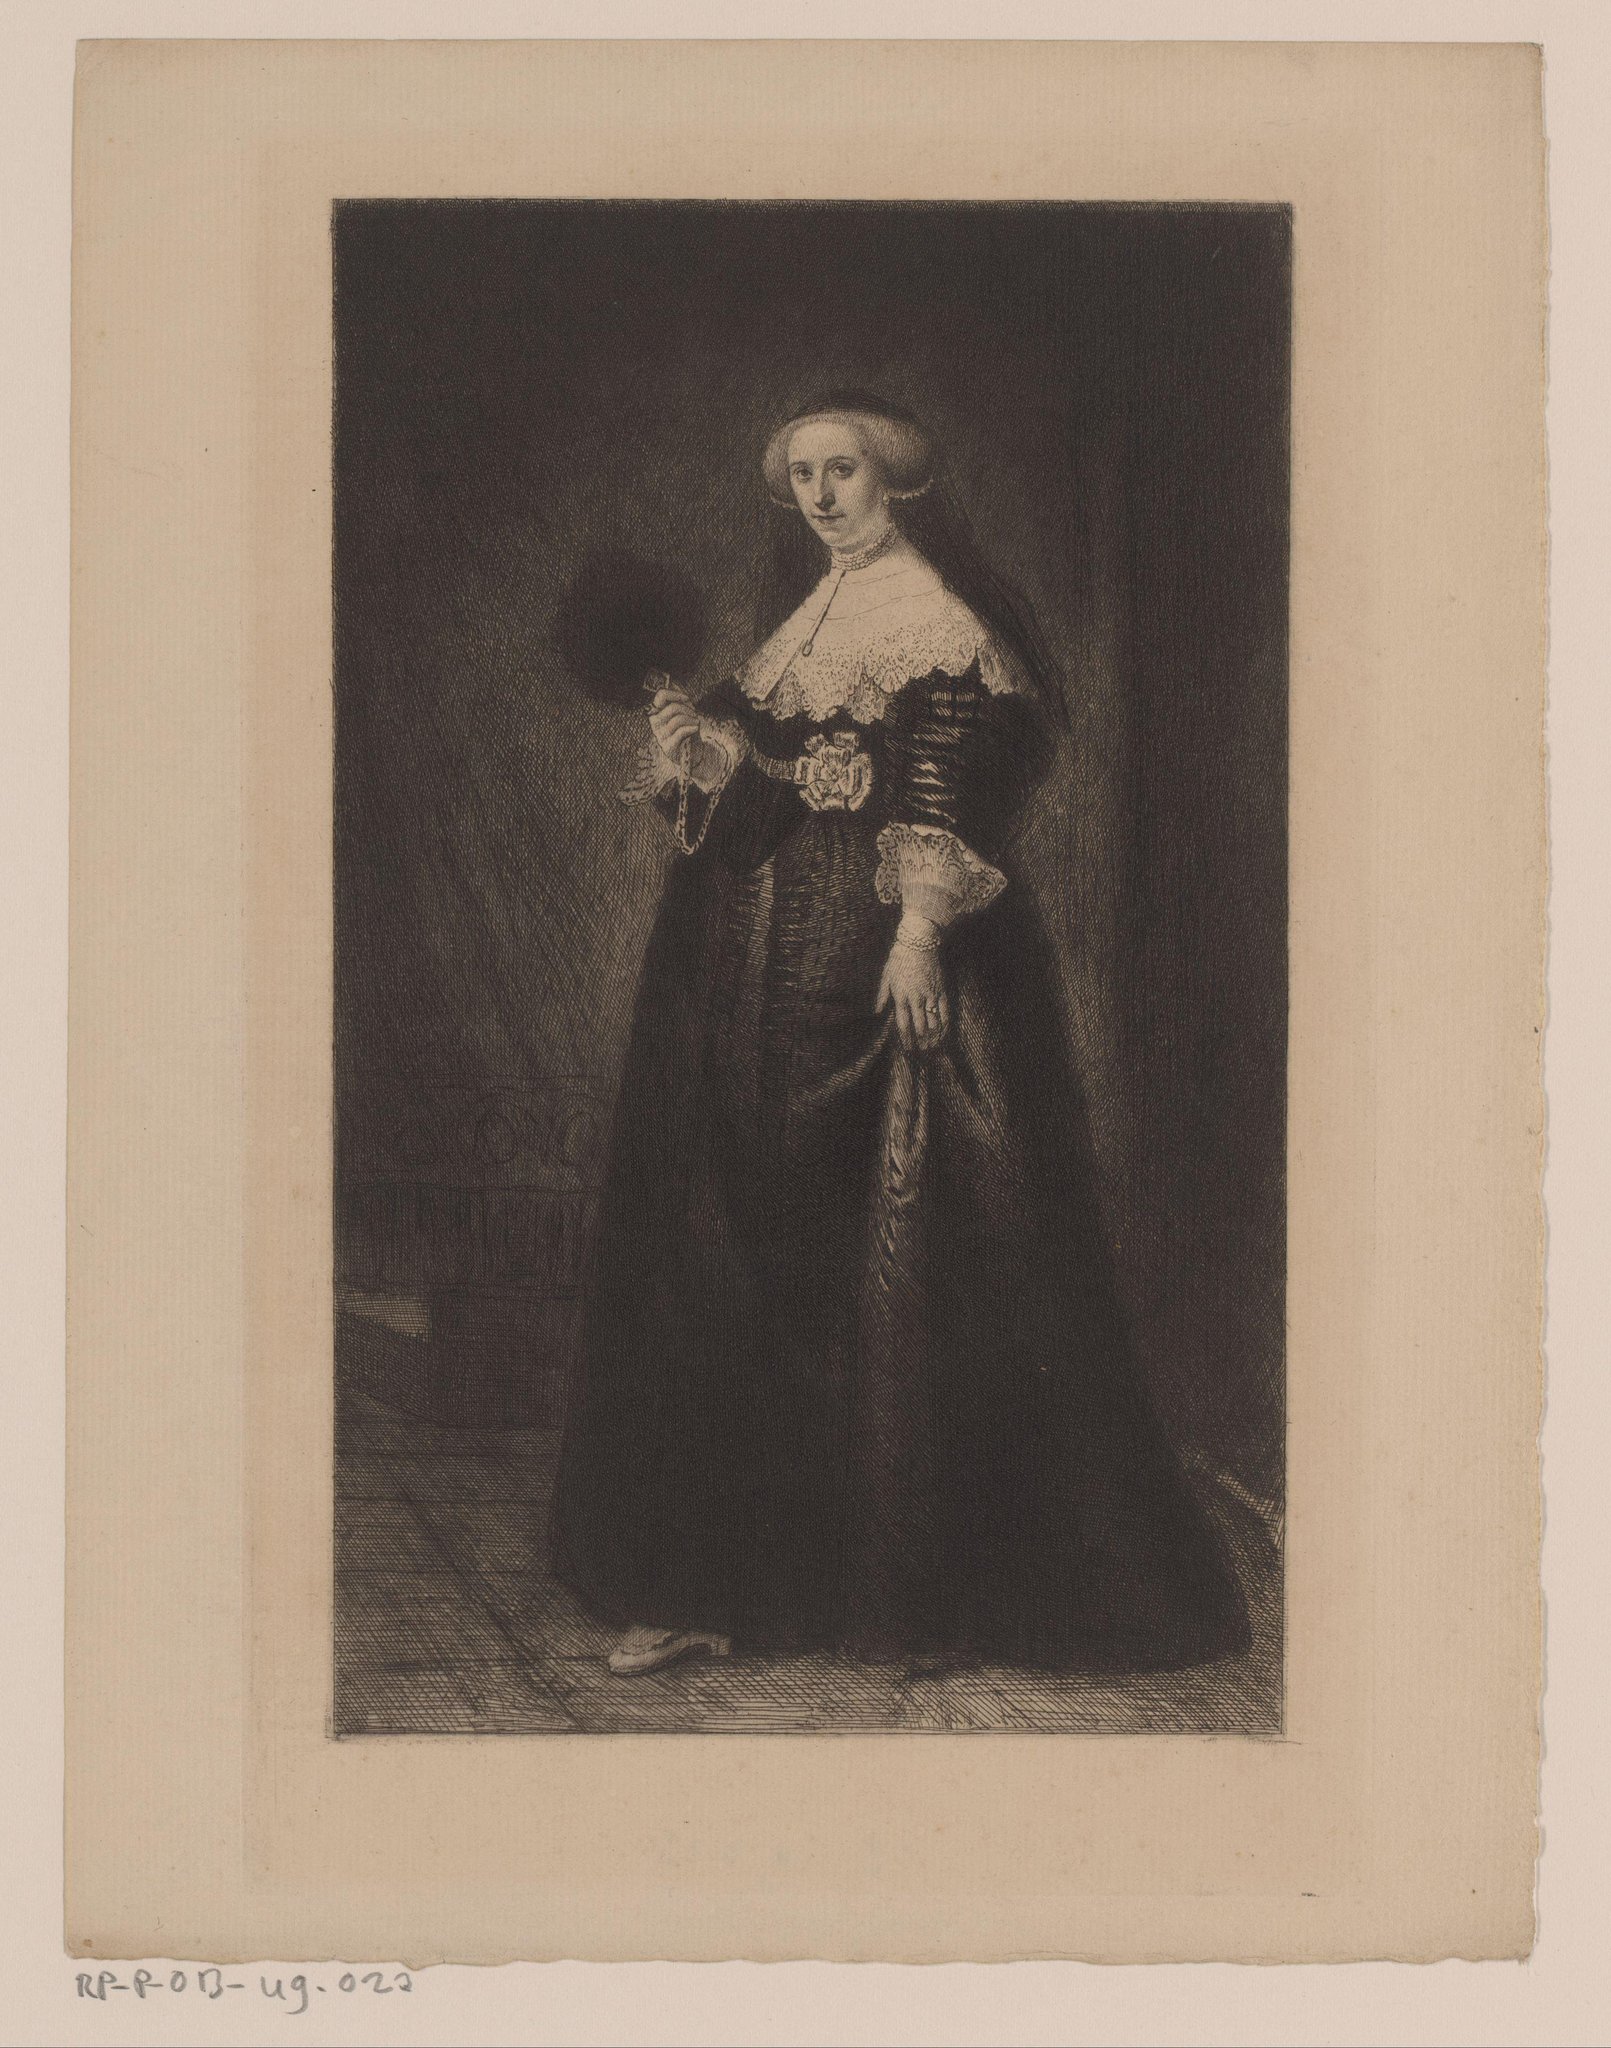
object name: print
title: Portret van Marten Soolmans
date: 1841-1879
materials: paper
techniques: drypoint, etching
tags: anonymous historical person portrayed alone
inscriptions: collector's mark: Lugt 2228